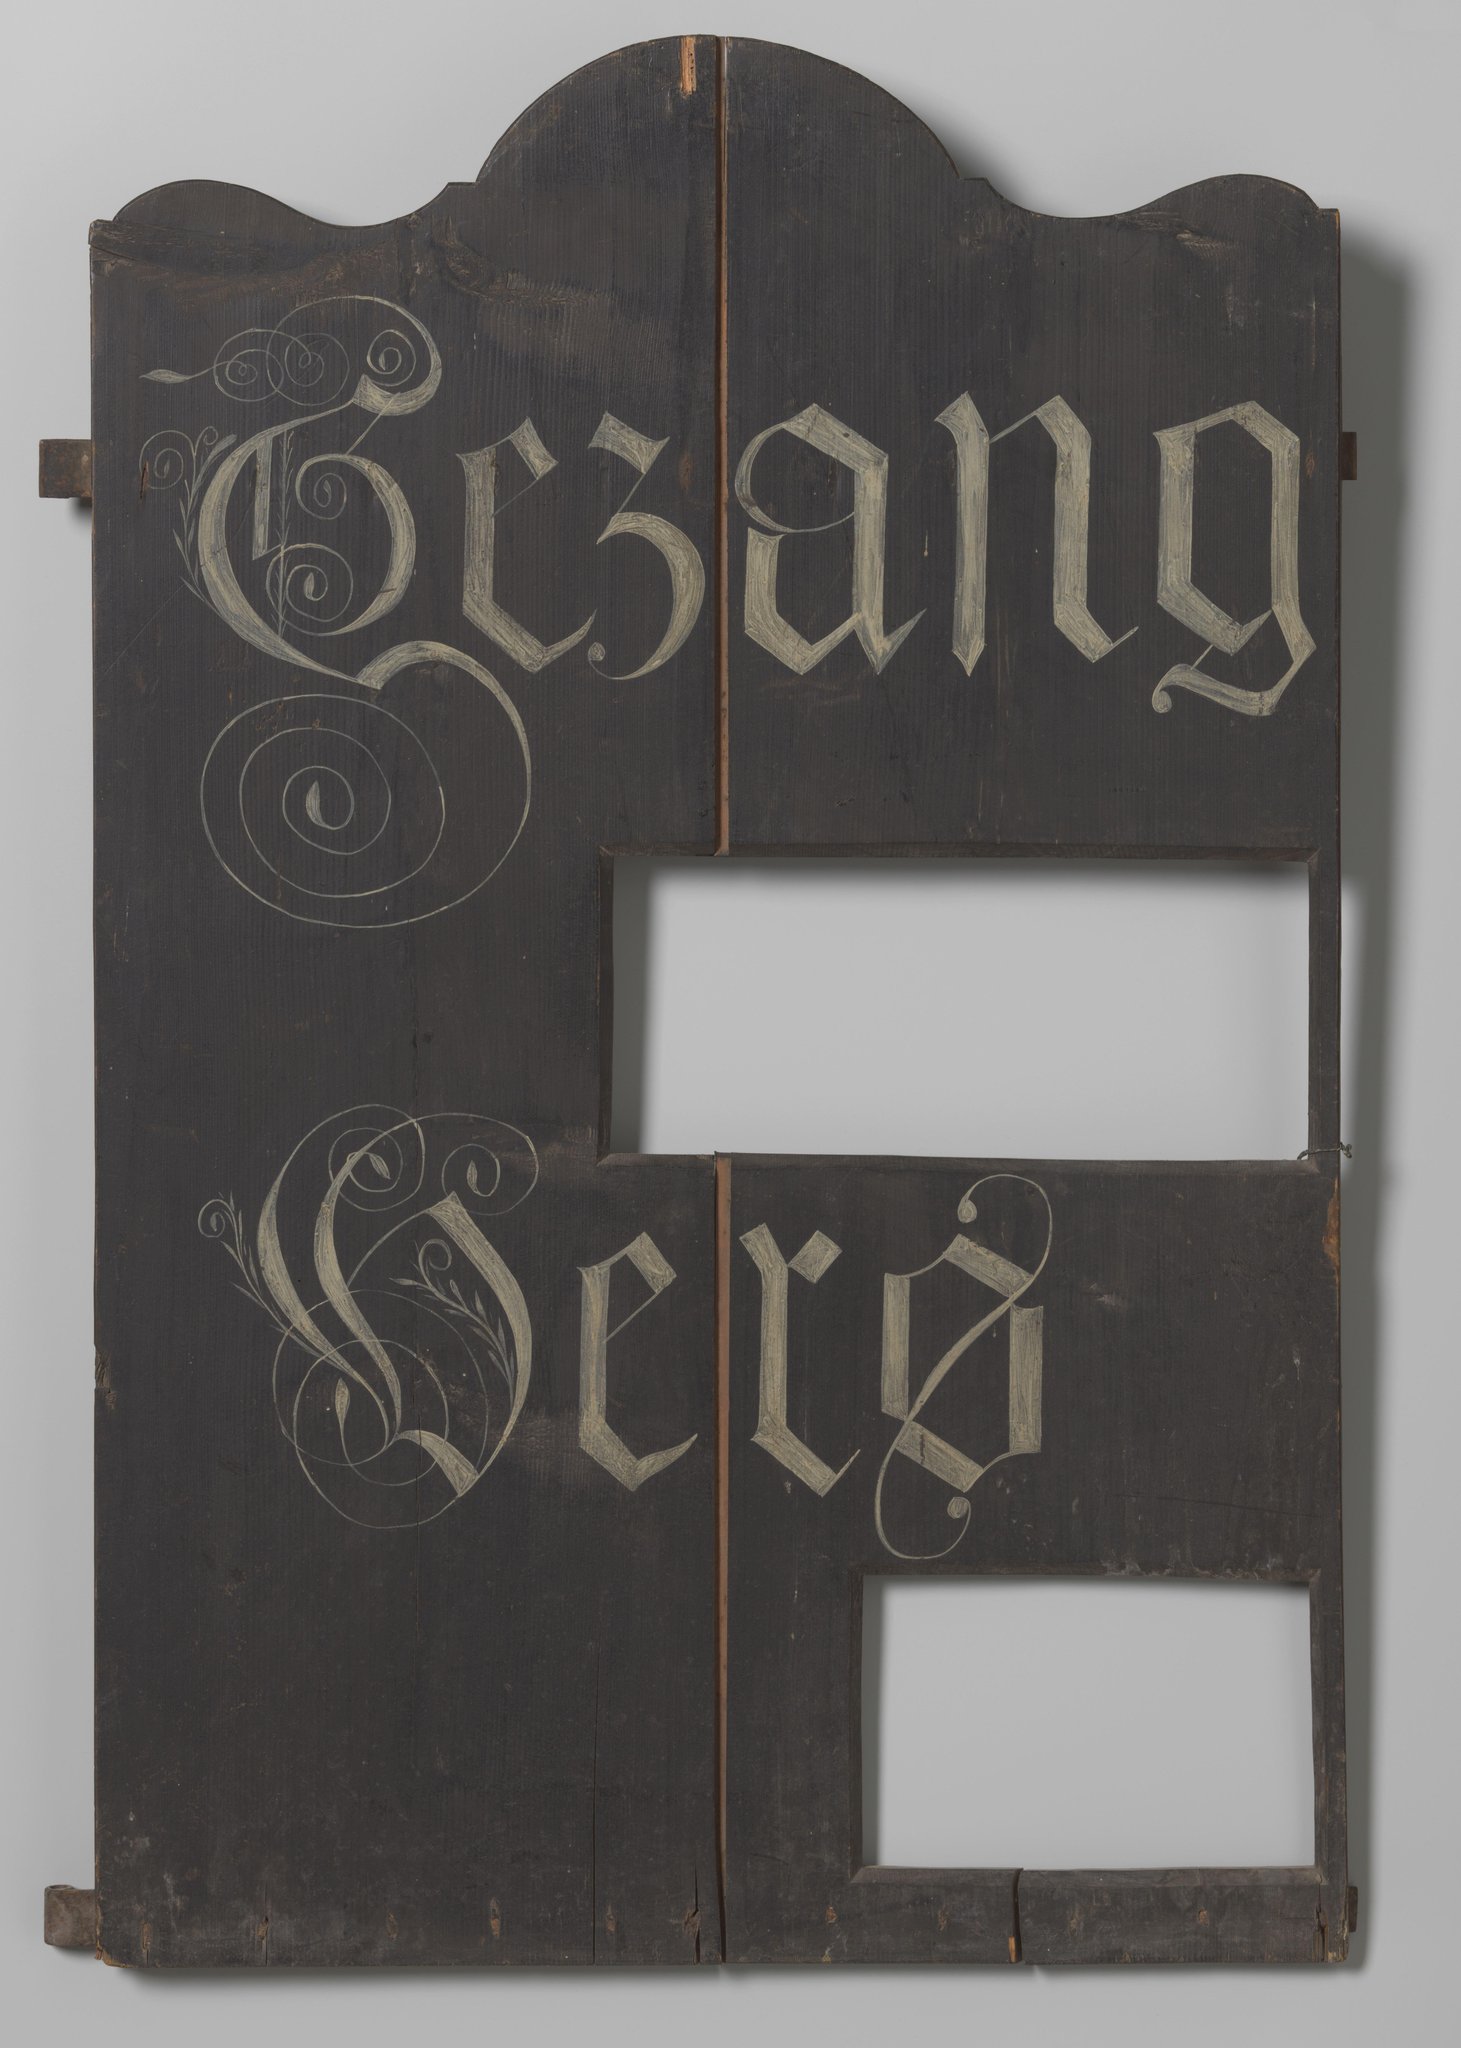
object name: furniture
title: Gezangbord met tekst : psalm en pauze"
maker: Anonymous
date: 1400-1950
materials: wood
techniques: painted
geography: northern netherlands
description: Gezangbord met de tekst: "psalm en pauze". Zie tevens; BK-NM-6057/6059.